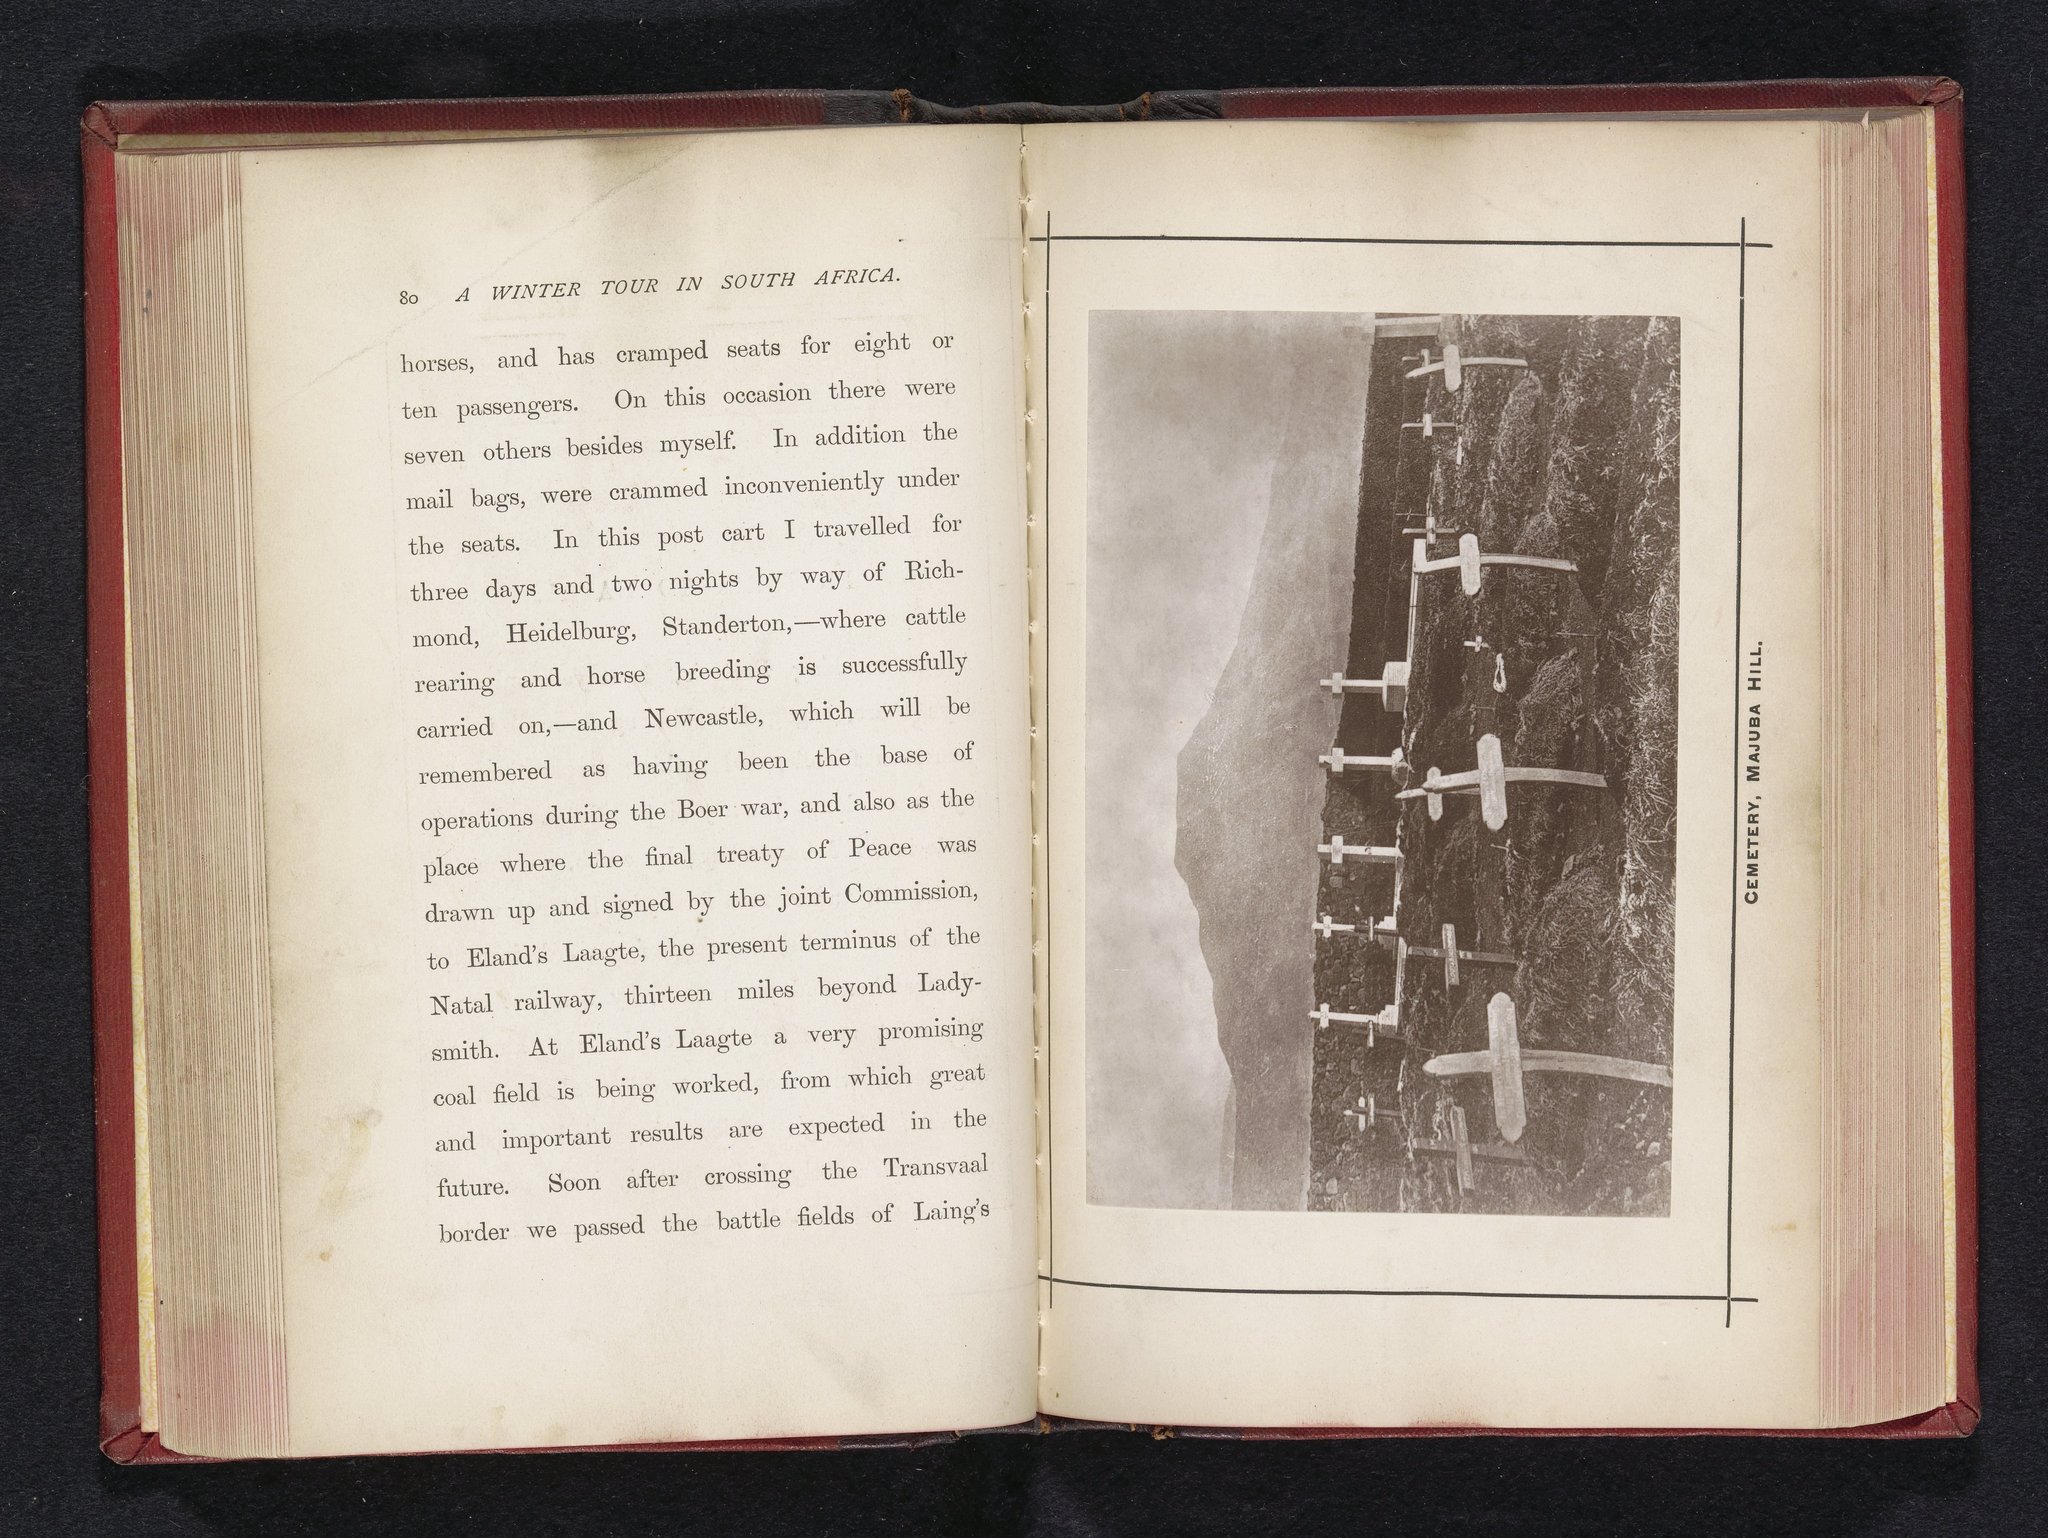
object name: photomechanical print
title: Cemetery, Majuba Hill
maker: Anonymous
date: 1888-1890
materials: paper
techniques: woodburytype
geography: south africa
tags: churchyard, cemetery